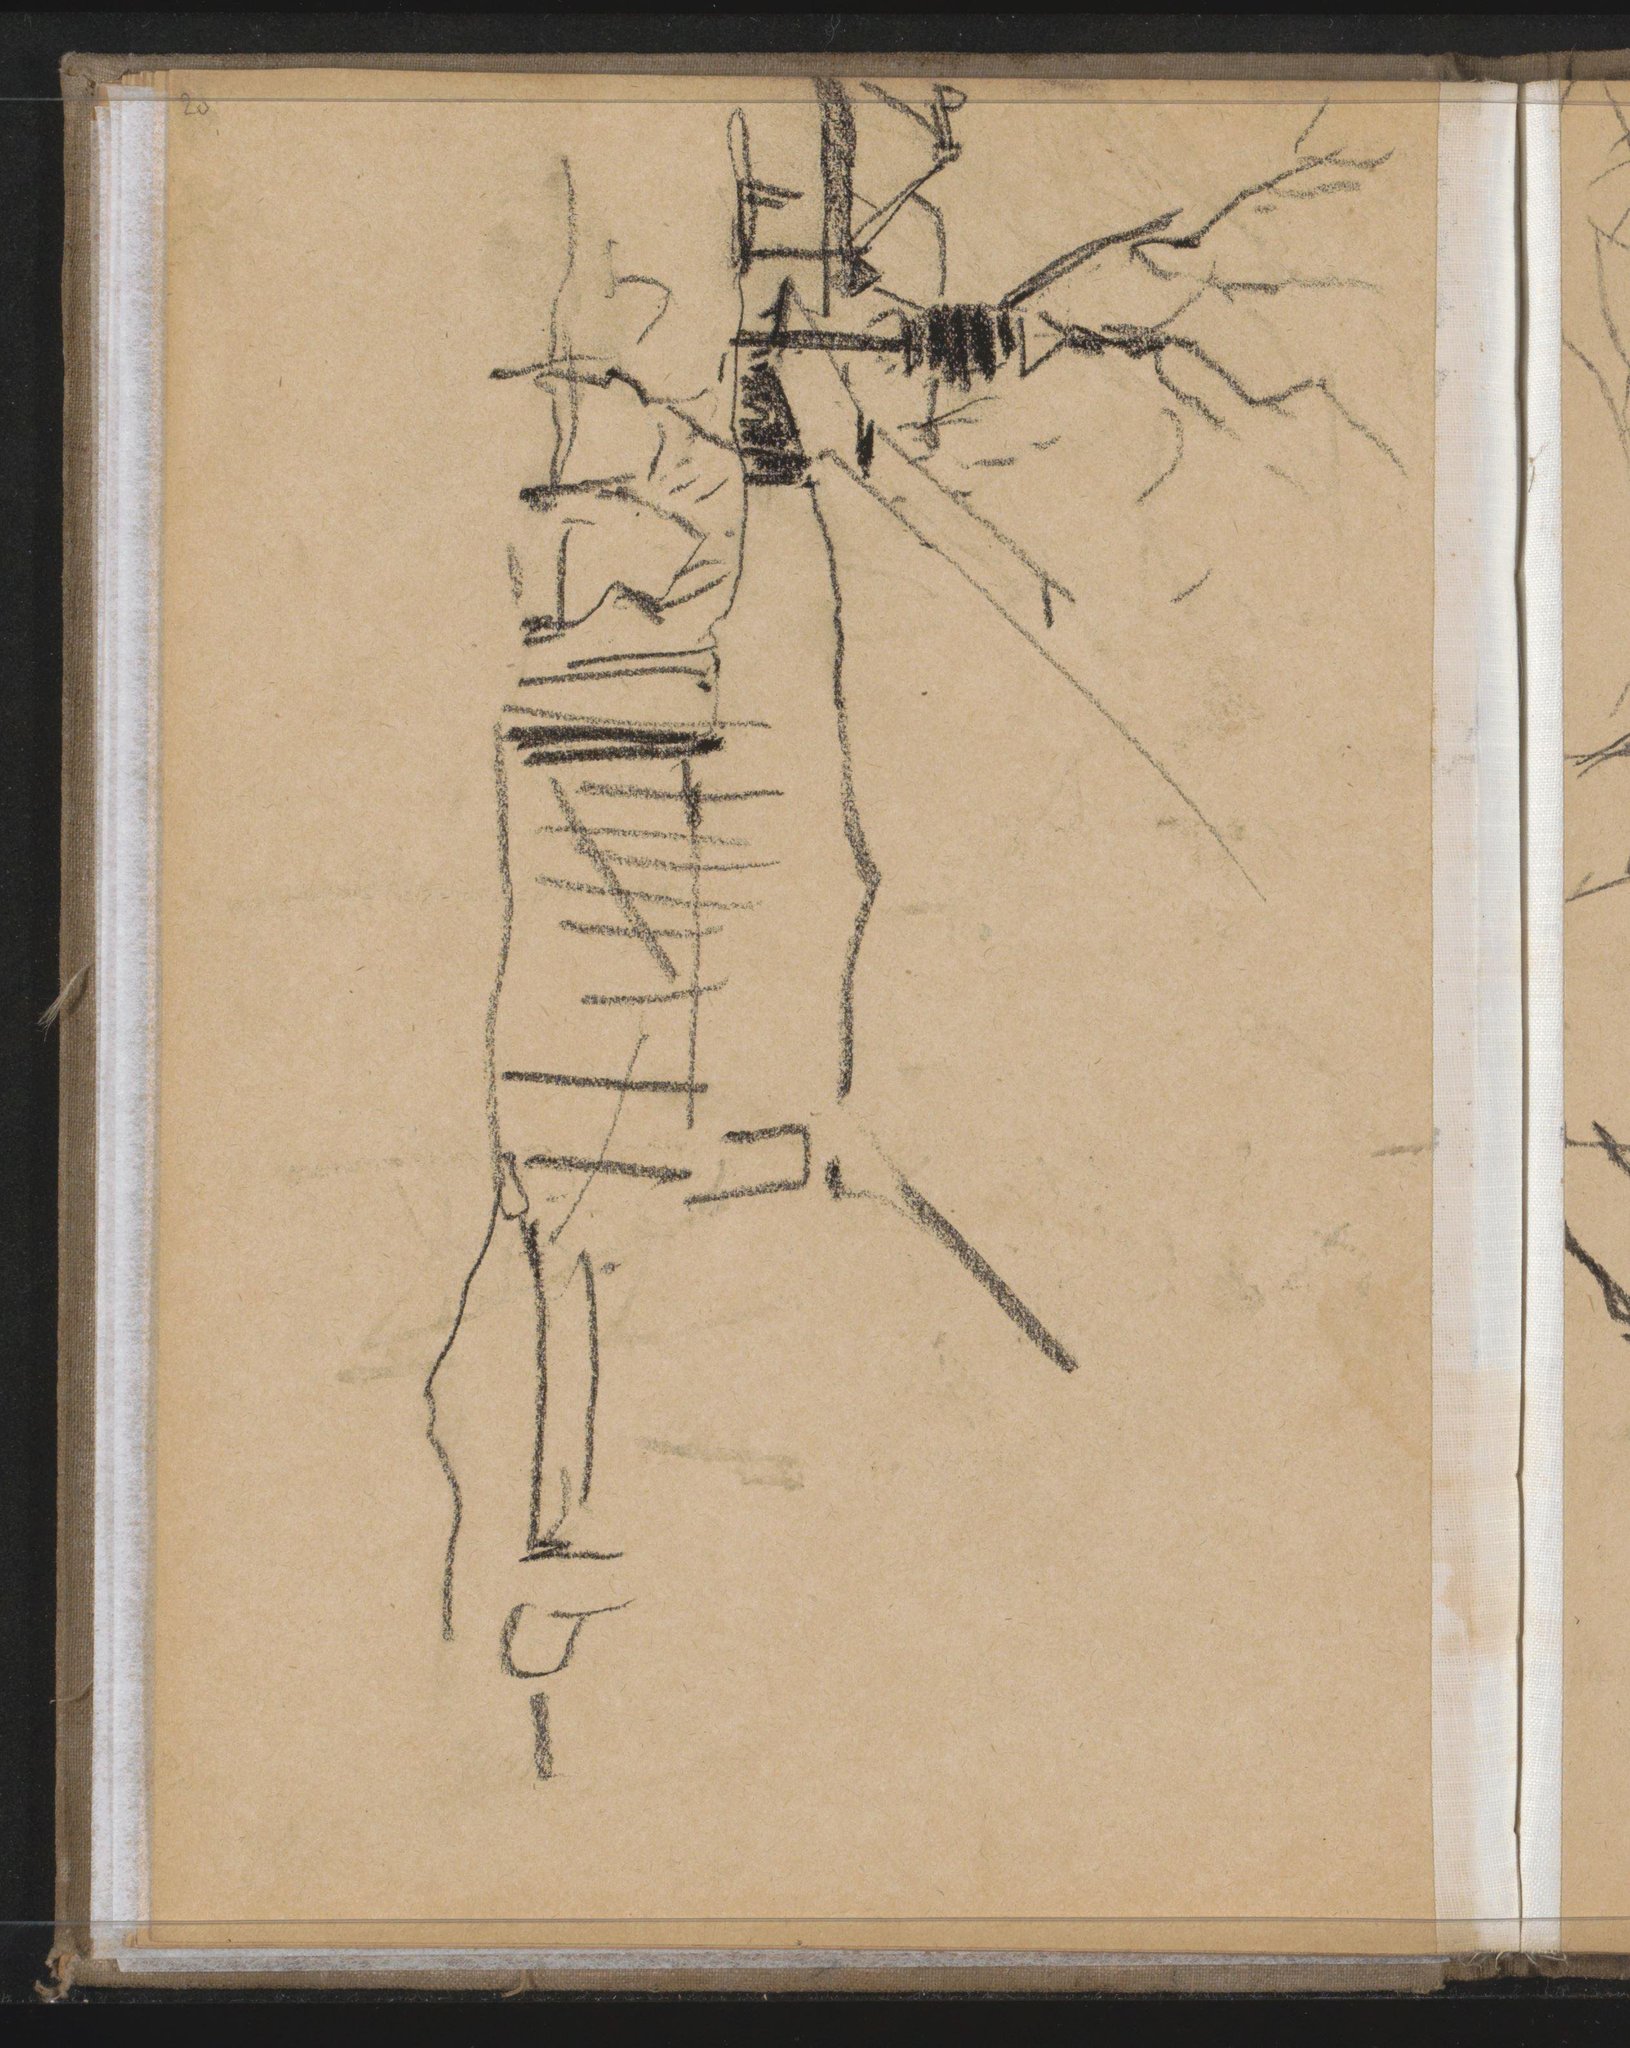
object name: sketchbook leaf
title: Gezicht op boerderijen te Ede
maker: willem witsen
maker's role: draughtsman, painter, print maker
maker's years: 1860-1923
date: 1893-1897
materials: chalk, paper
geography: ede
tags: rural housing, e.g. country-house, villa, cottage, farm (building)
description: Pagina 20 uit een schetsboek met 28 bladen.